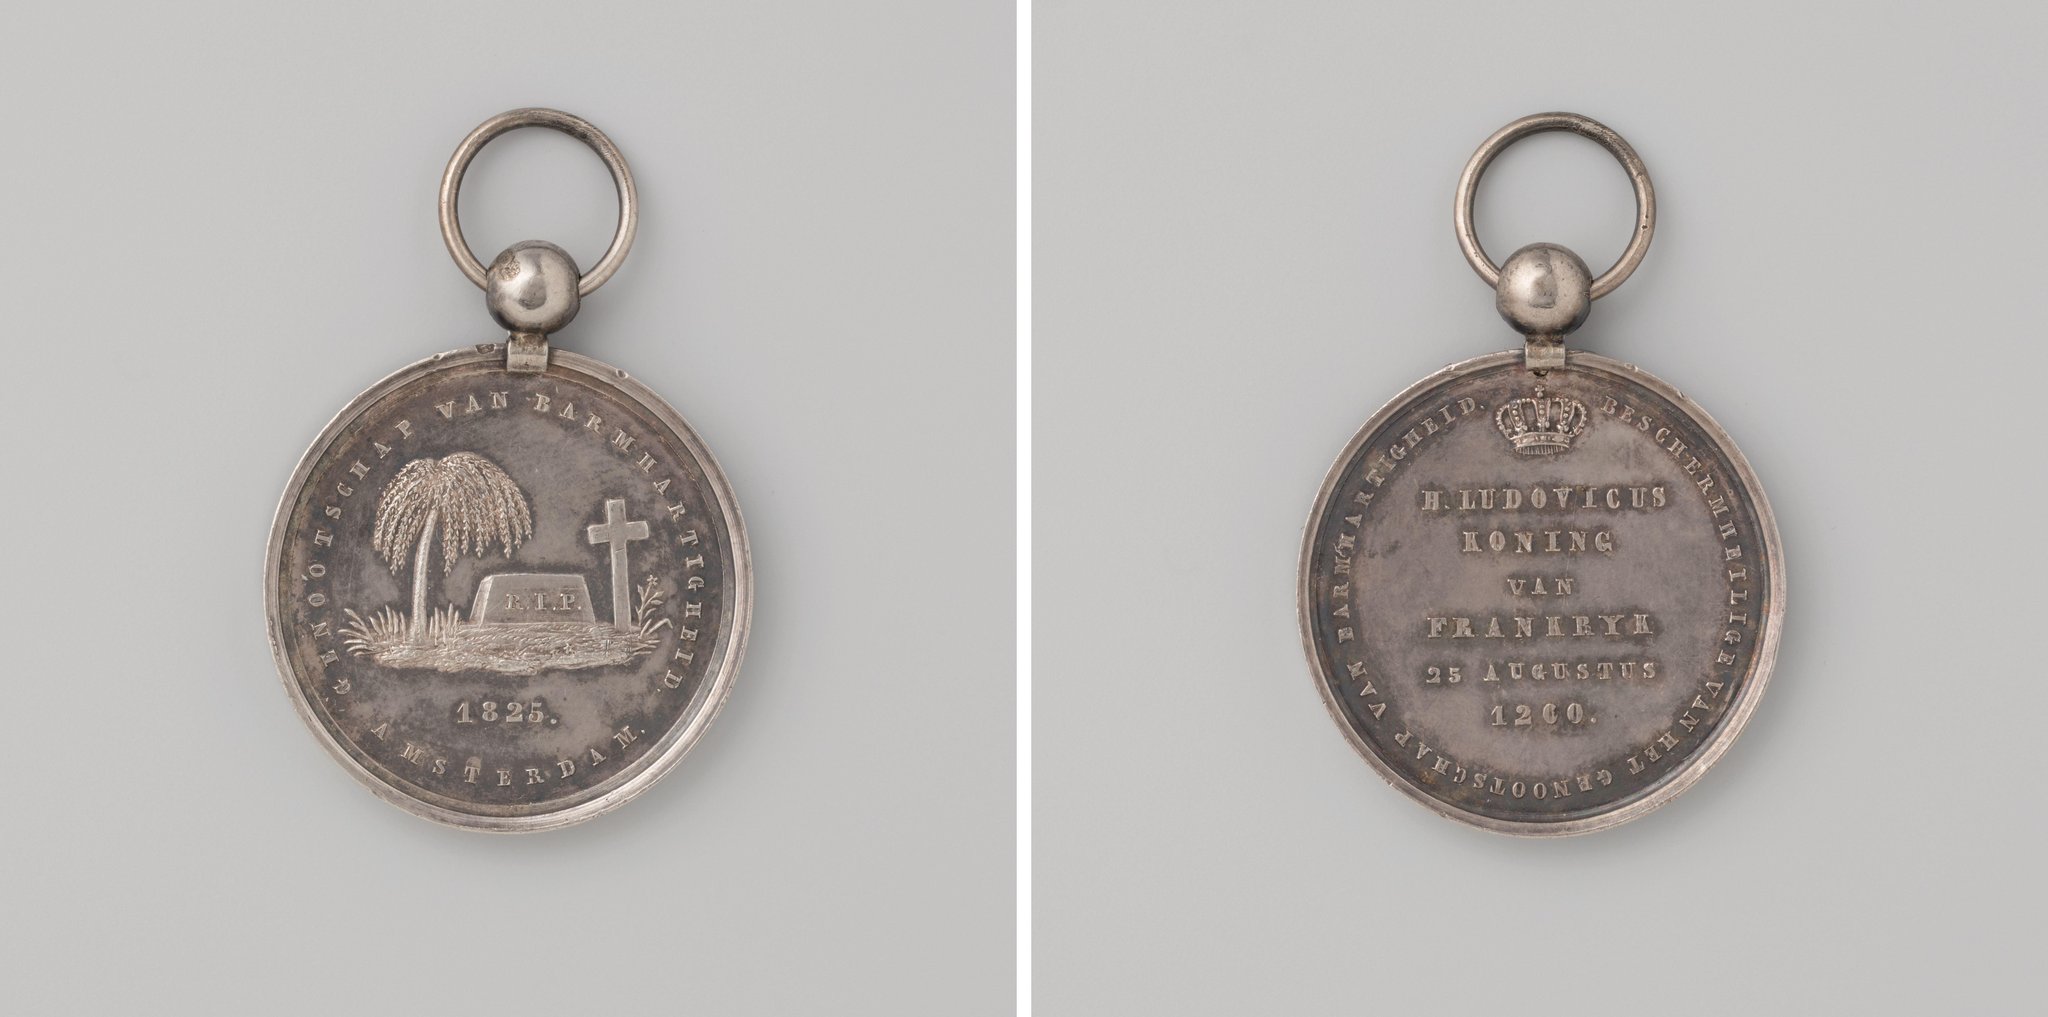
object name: medal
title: Genootschap van Barmhartigheid te Amsterdam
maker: Anonymous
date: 1825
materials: silver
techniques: striking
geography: netherlands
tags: amsterdam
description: Zilveren penning aan draagoog en draagring. Voorzijde: tombe, treurwilg en kruis boven jaartal binnen omschrift. Keerzijde: opschrift onder kroon binnen omschrift